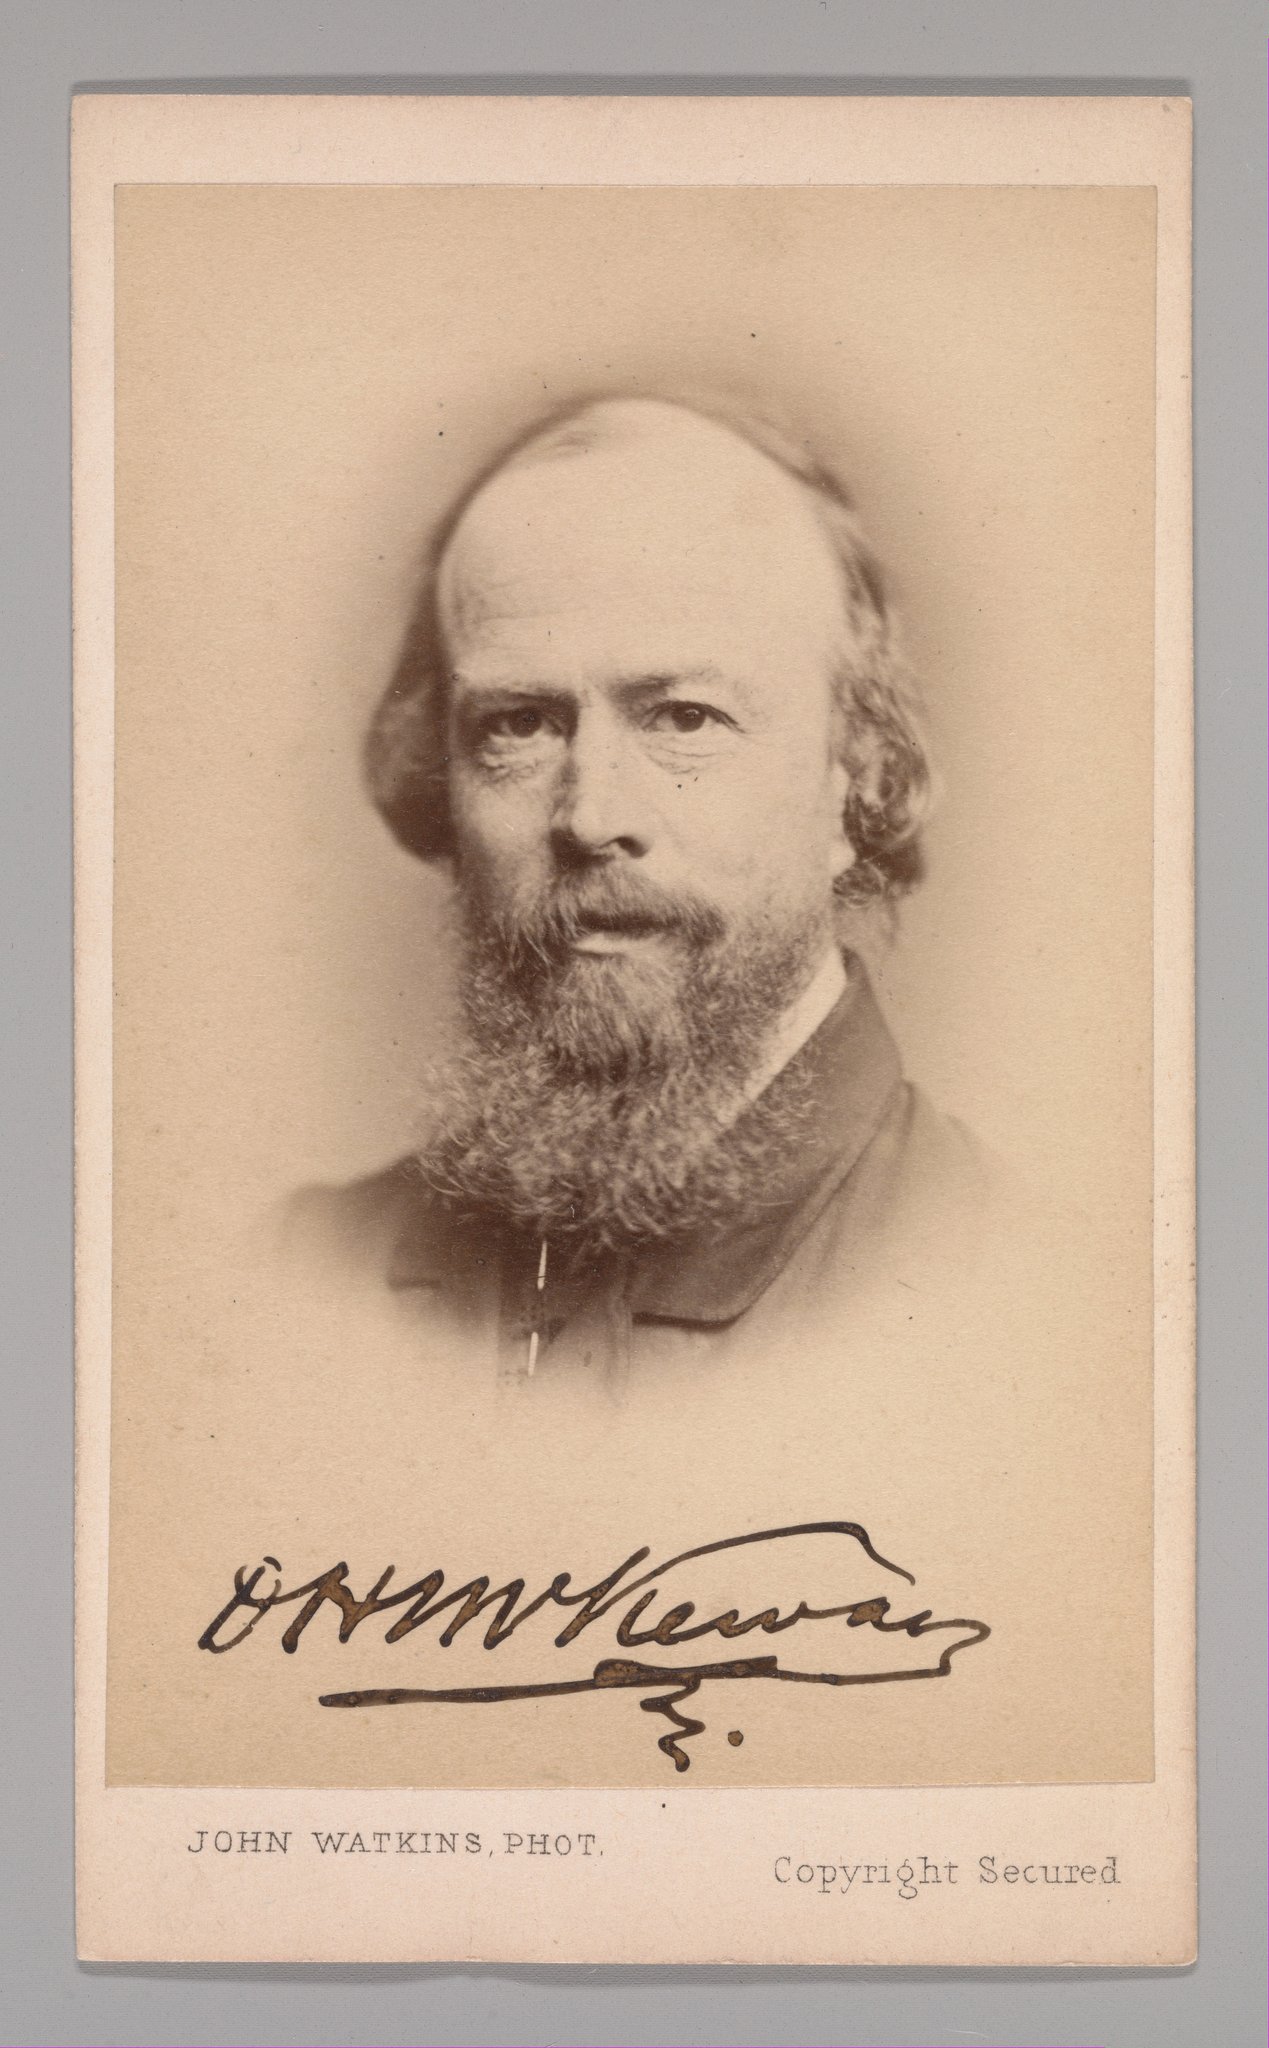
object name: carte de visite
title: [David Hall McKewan]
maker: john and charles watkins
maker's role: photography studio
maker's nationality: british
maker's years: 1840-1875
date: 1860-1869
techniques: albumen silver print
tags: men,portraits